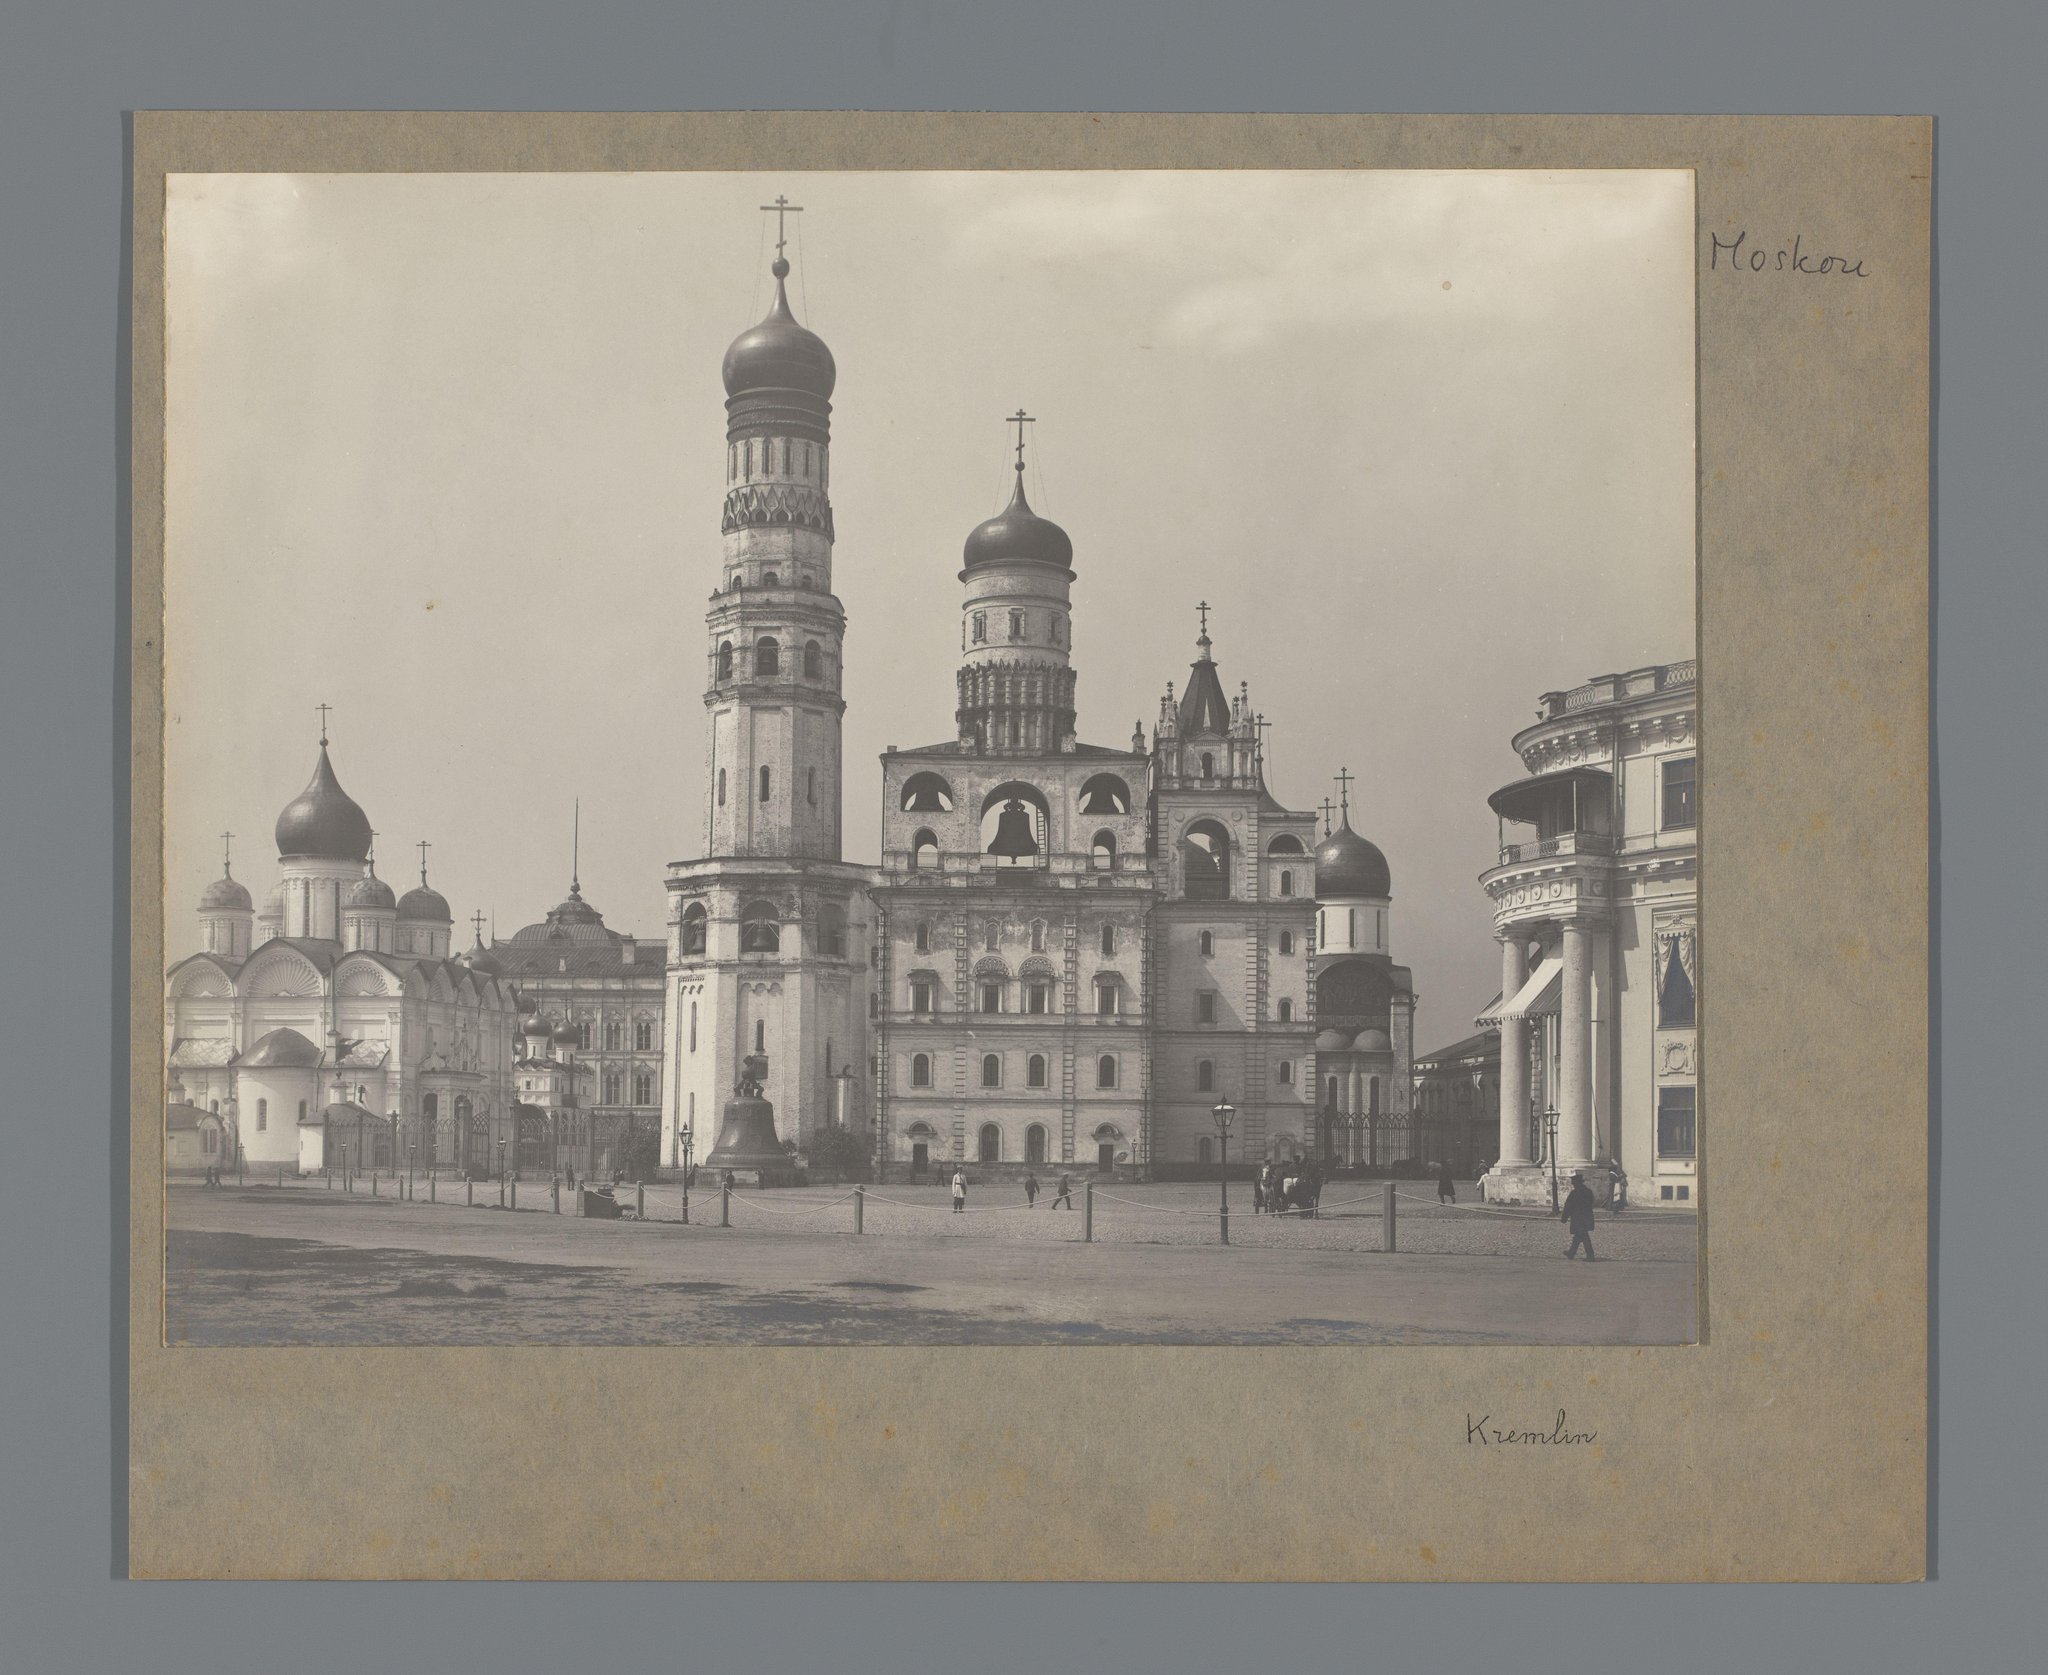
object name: photograph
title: Moskou. Kremlin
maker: Anonymous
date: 1880-1930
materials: photographic support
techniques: gelatin silver print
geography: russia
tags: kremlin